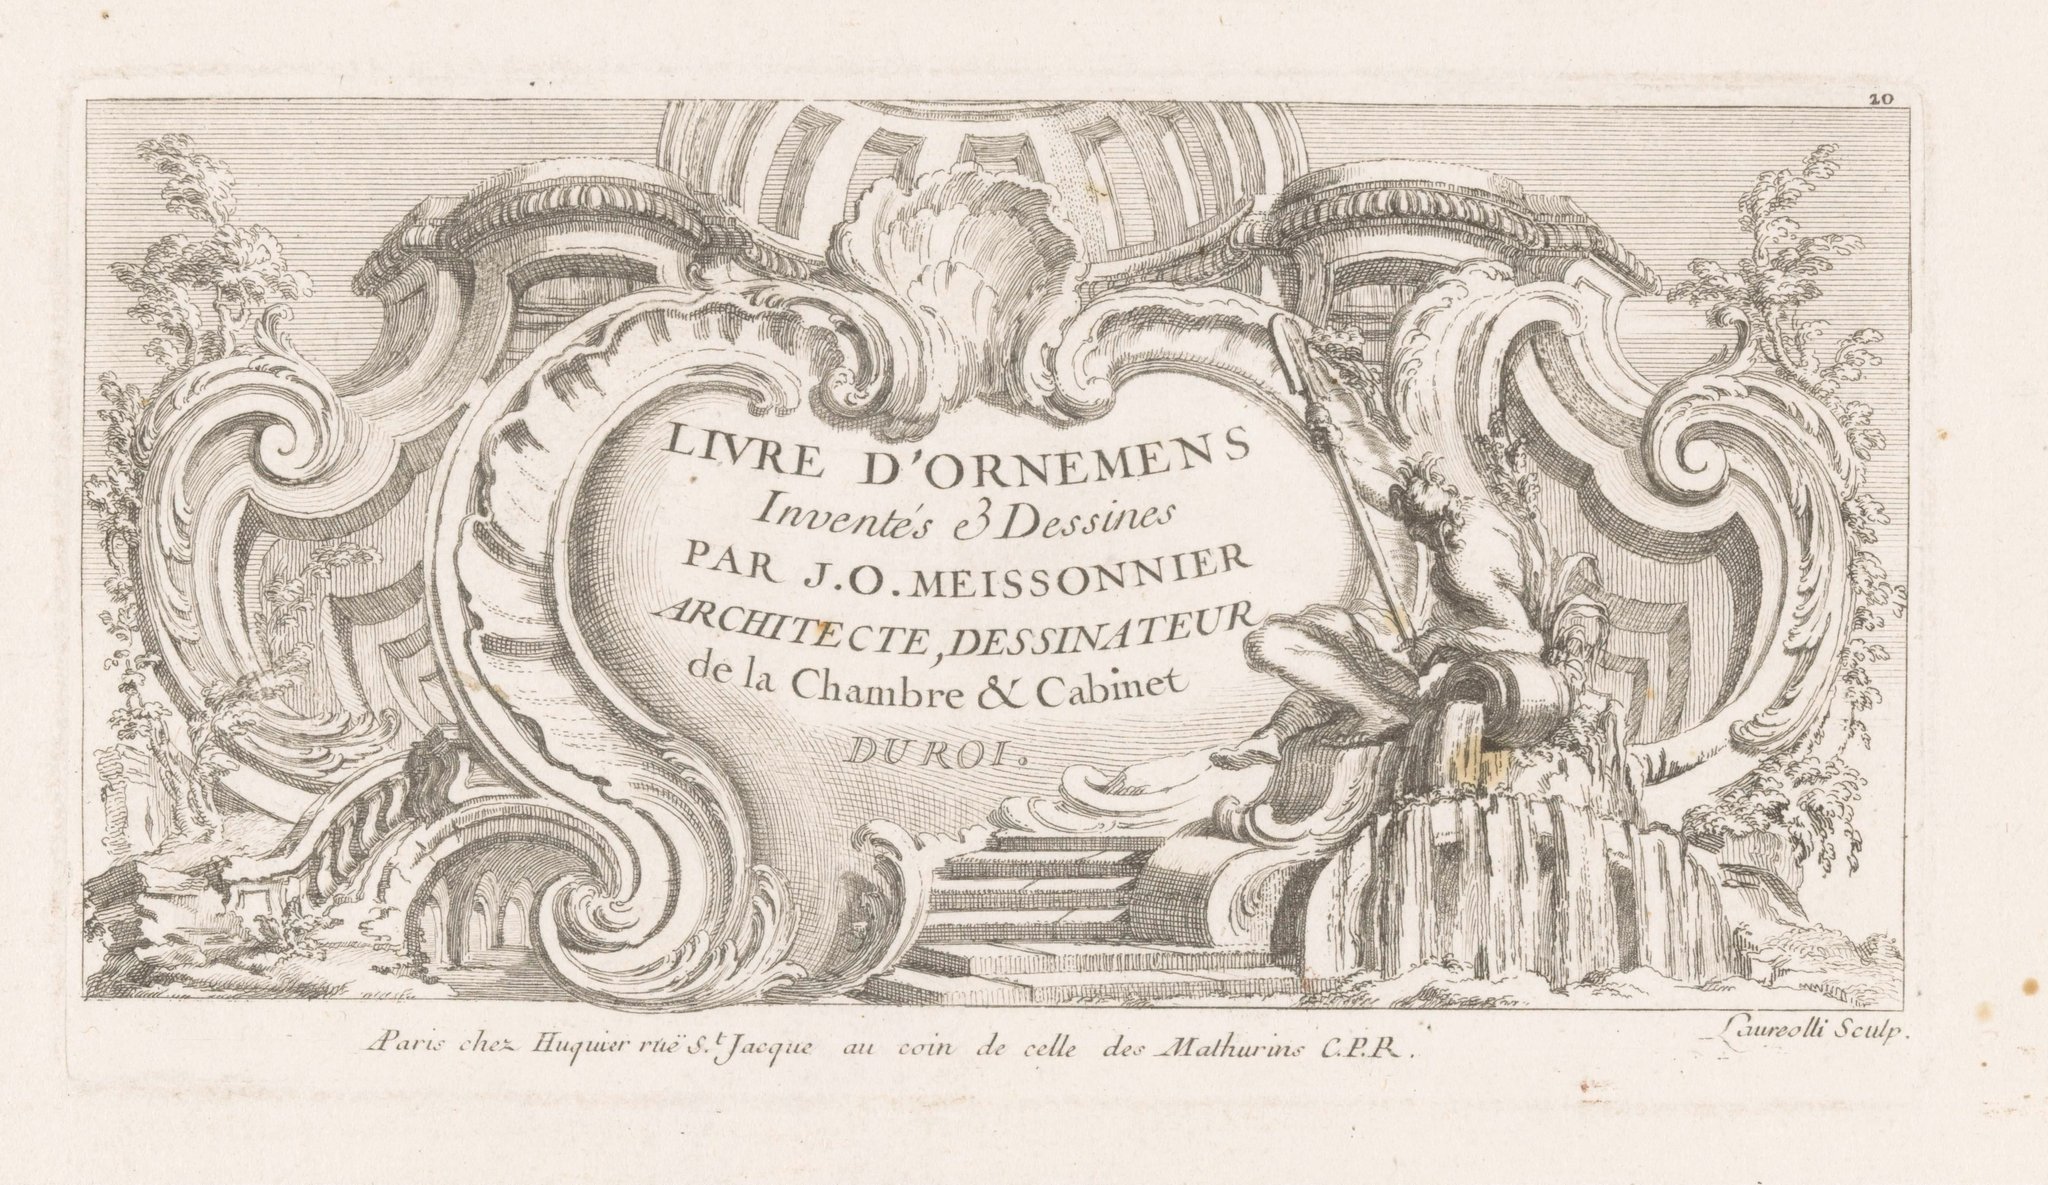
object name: ornament print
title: Cartouche met man en kruik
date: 1738-1749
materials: paper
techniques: etching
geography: paris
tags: sitting figure, jar, jug (used as drinking-vessel), ornament ~ cartouche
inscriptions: collector's mark: Lugt 2228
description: Een rocaille cartouche met de serietitel. Rechts zit een man op de rug gezien met een staf op een kruik waar water uit stroomt. Prentnummer 20.